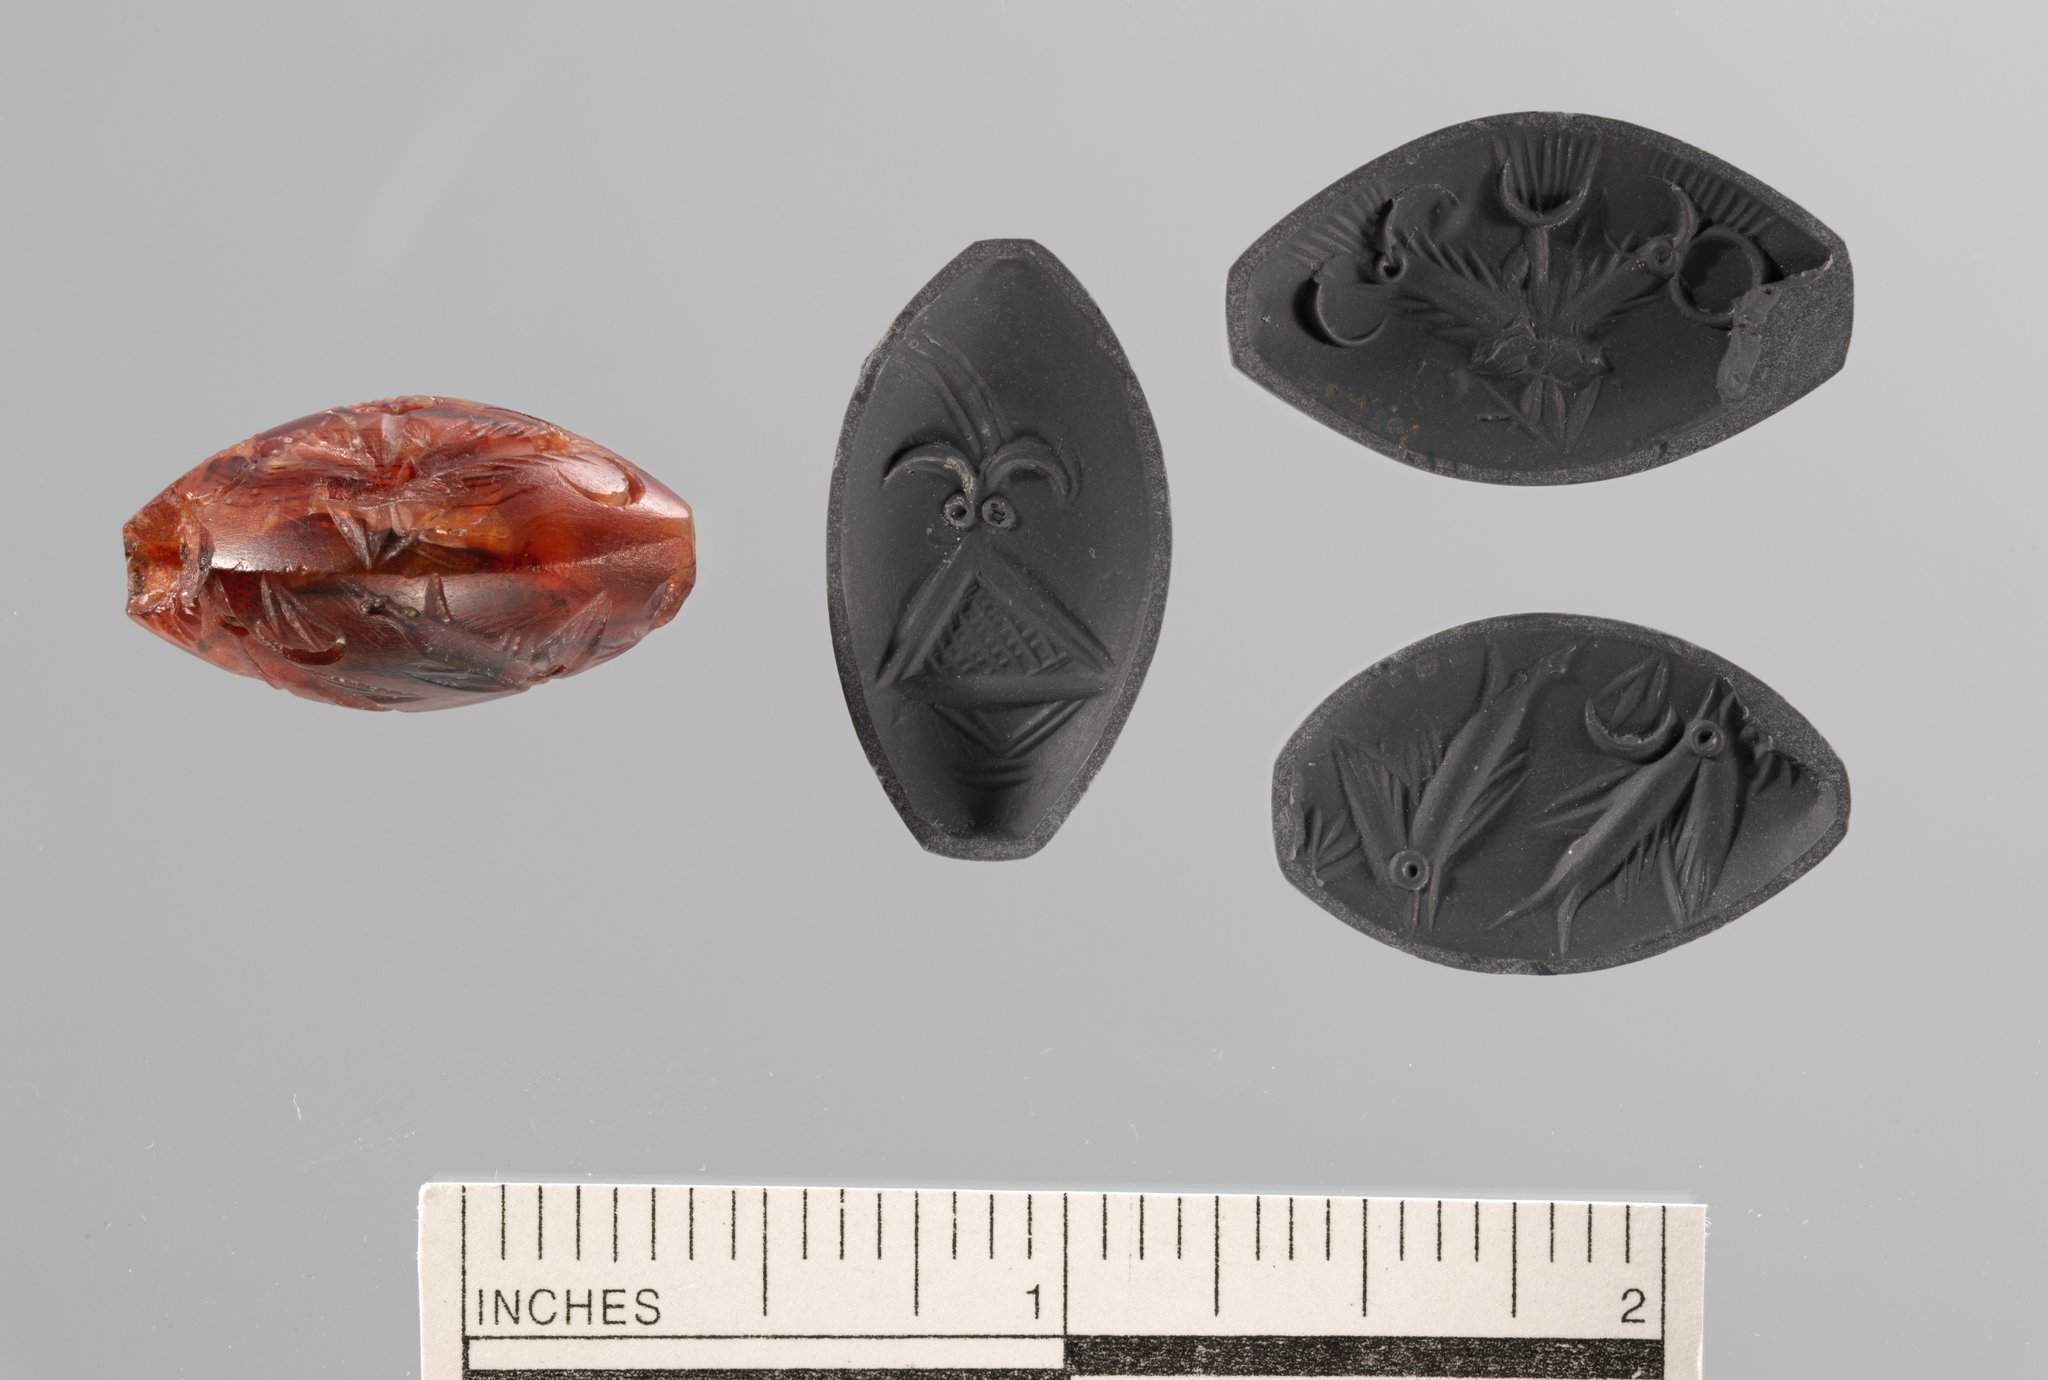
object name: prism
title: Carnelian Prism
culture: minoan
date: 1650-1500 BCE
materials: gemstone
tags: fish